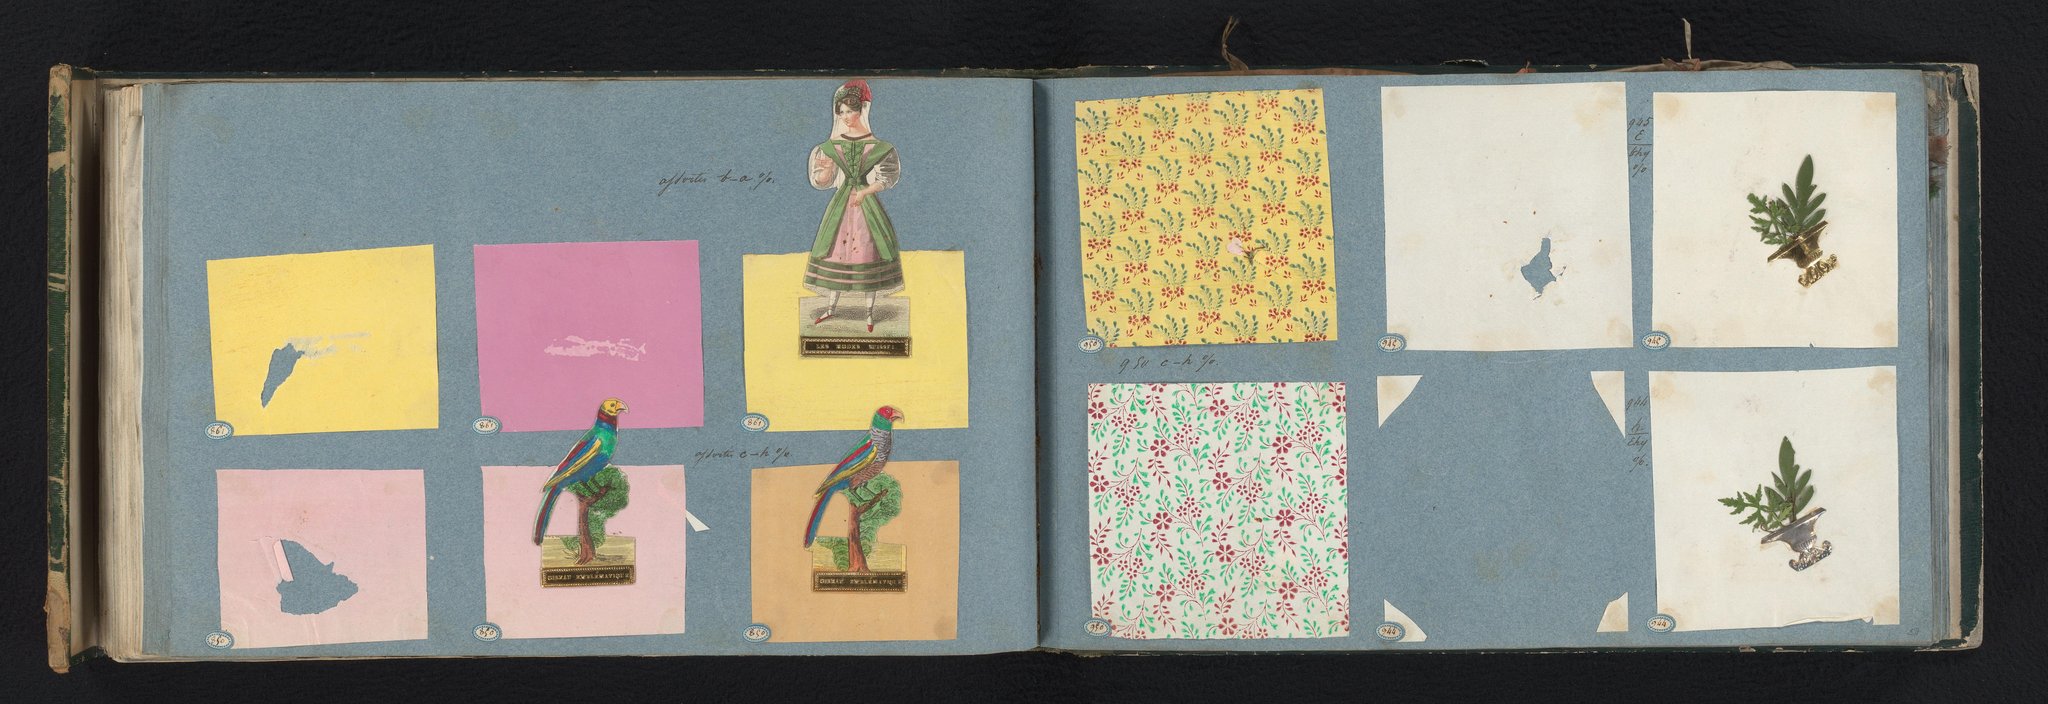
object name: album leaf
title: Twee bladzijden met stalen van gekleurd papier met opgeplakte figuren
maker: Anonymous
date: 1830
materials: gold leaf, ink, paper, silver leaf, watercolor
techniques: manufacturing, etching, hand coloring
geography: france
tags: ornaments ~ art, ornamental birds: parrot, folk costume, regional costume, flowers in a vase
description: Twee bladzijden met 5 complete stalen van gekleurde papieren met verschillende figuren. Links twee gedrukte en ingekleurde vignetten van papegaaien en een staande vrouw (mode van Zwitserland), opgeplakt op gekleurd papier. Rechts twee stalen met vignetten van vazen van goud- en zilverkleurig metaalpapier met groene bladeren. Bij de overige zes stalen zijn de vignetten weggehaald. Alle stalen voorzien van etiketten met nummers (861-944) en handgeschreven codes. Onderdeel van het stalenboek geschonken door de dames Van Rijn, vermoedelijk van een Franse papierfabrikant van luxe papieren, of diens vertegenwoordiger in Nederland, ca. 1830.